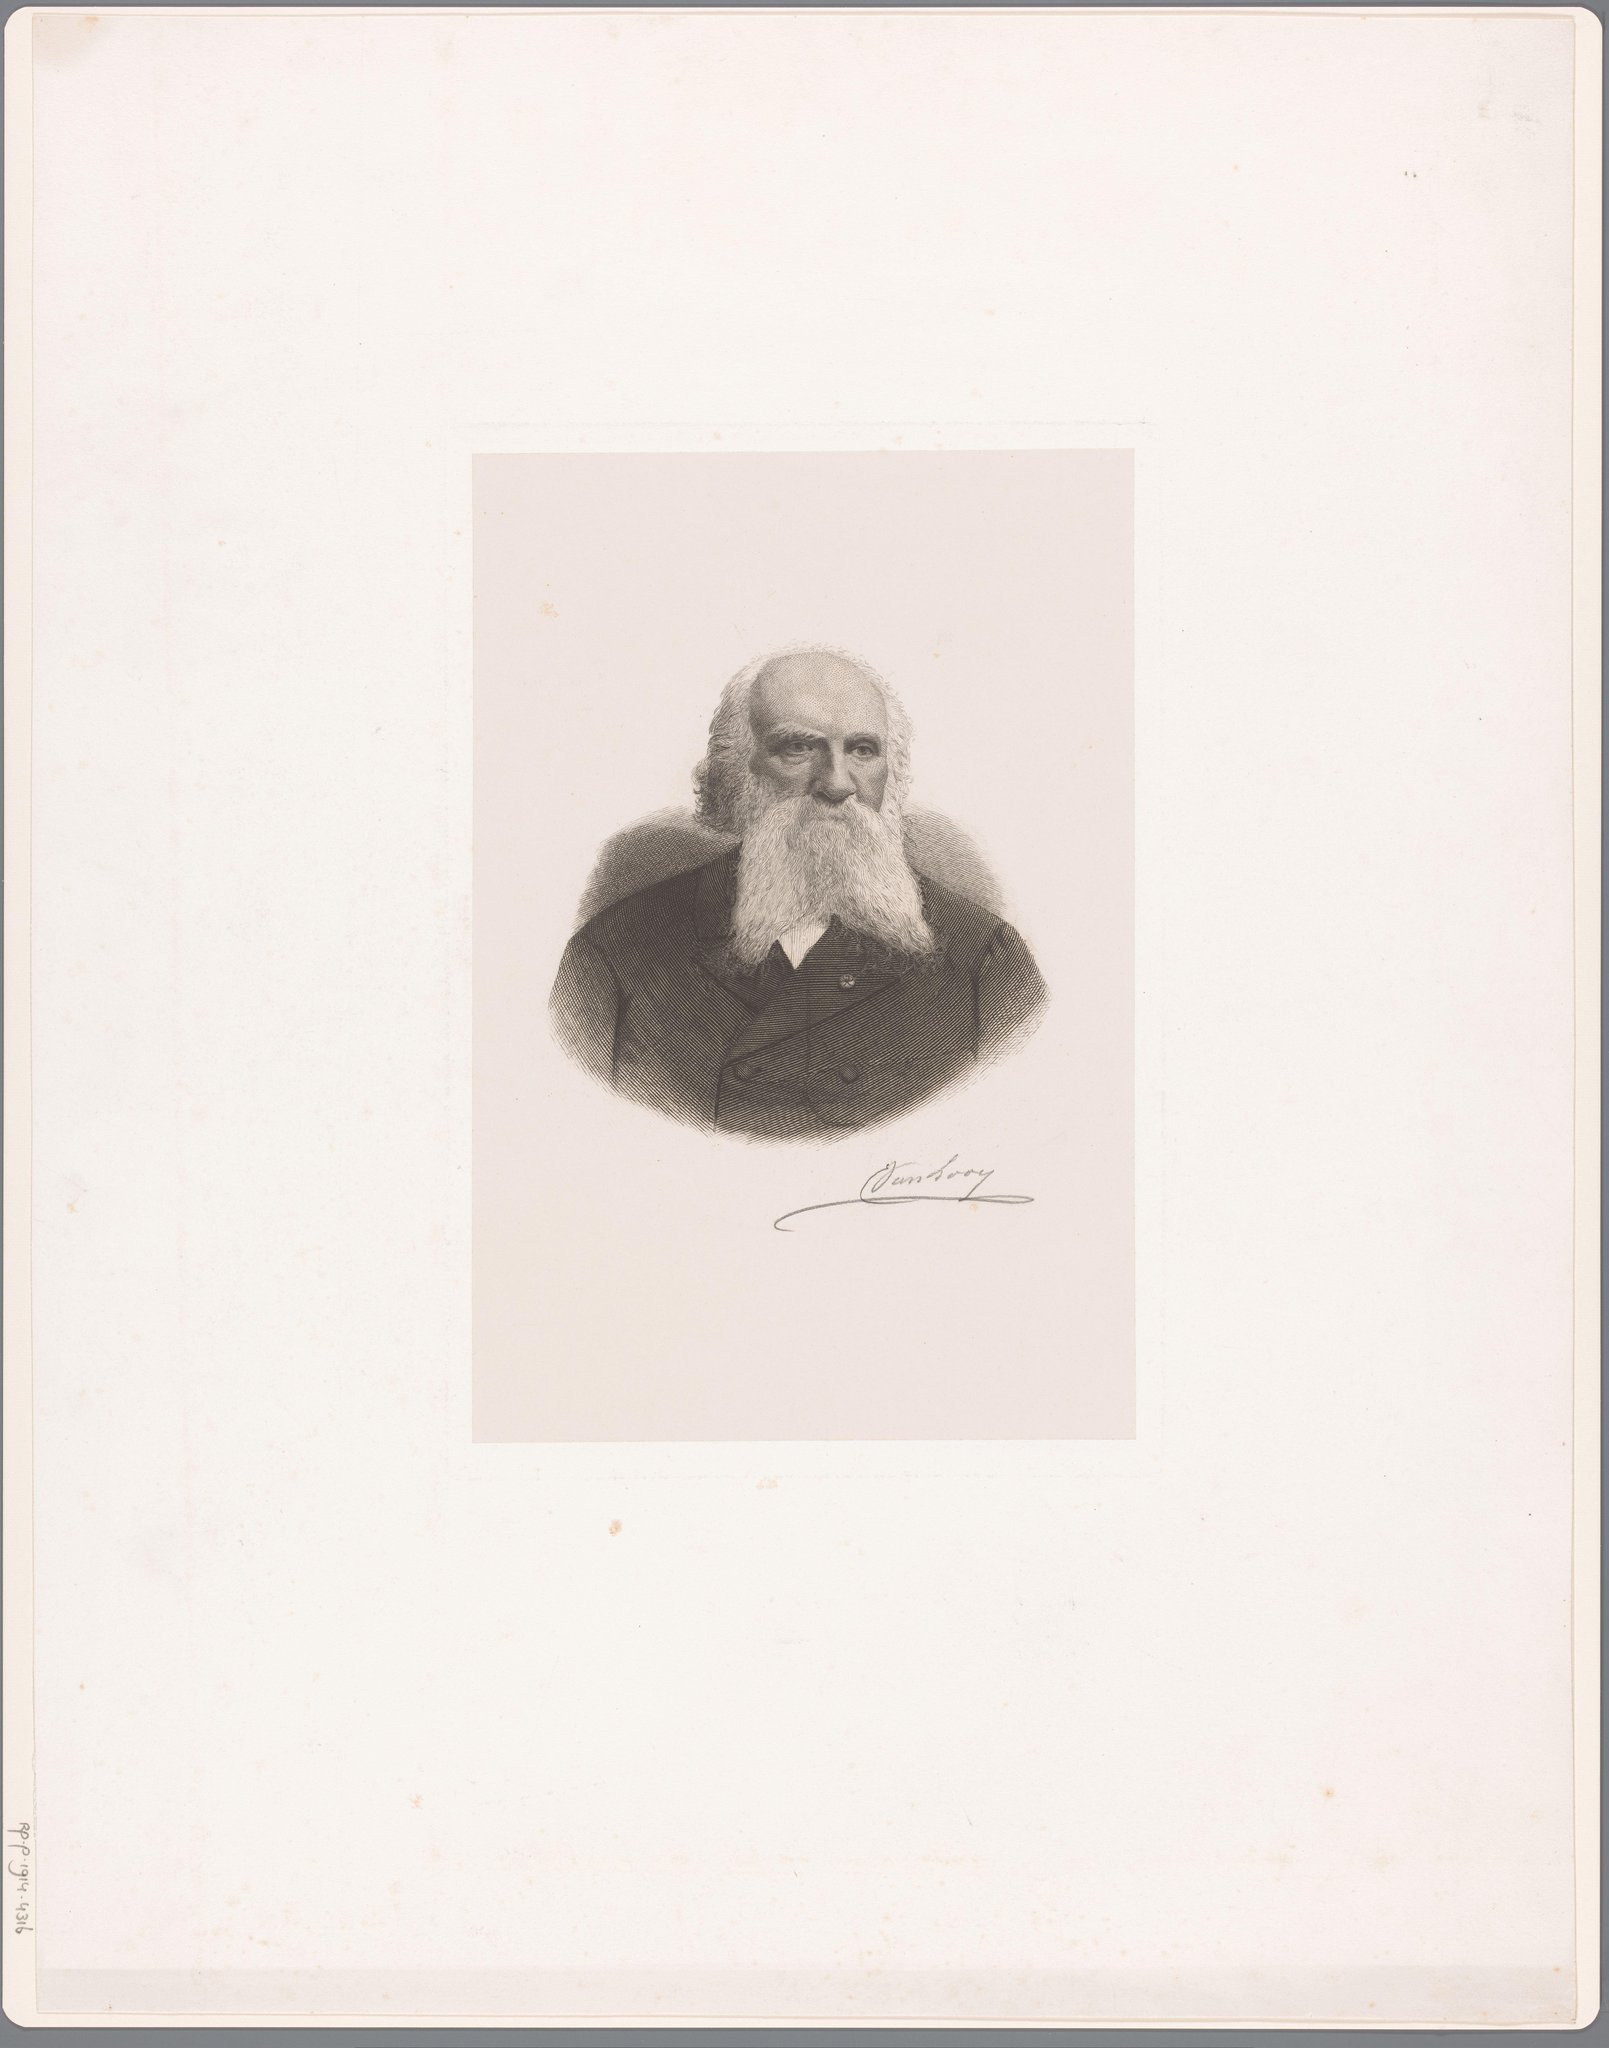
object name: print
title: Portret van Jacques Vekemans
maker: joseph edouard van looy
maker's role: print maker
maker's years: 1871-1896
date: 1881-1912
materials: paper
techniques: etching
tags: historical persons, antwerp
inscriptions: collector's mark: Lugt 2228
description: Sterfdatum van de prentmaker is onbekend. Daarom is voor de bepaling van de rechten van dit object gebruik gemaakt van de verwervingsdatum Rijksmuseum Amsterdam.